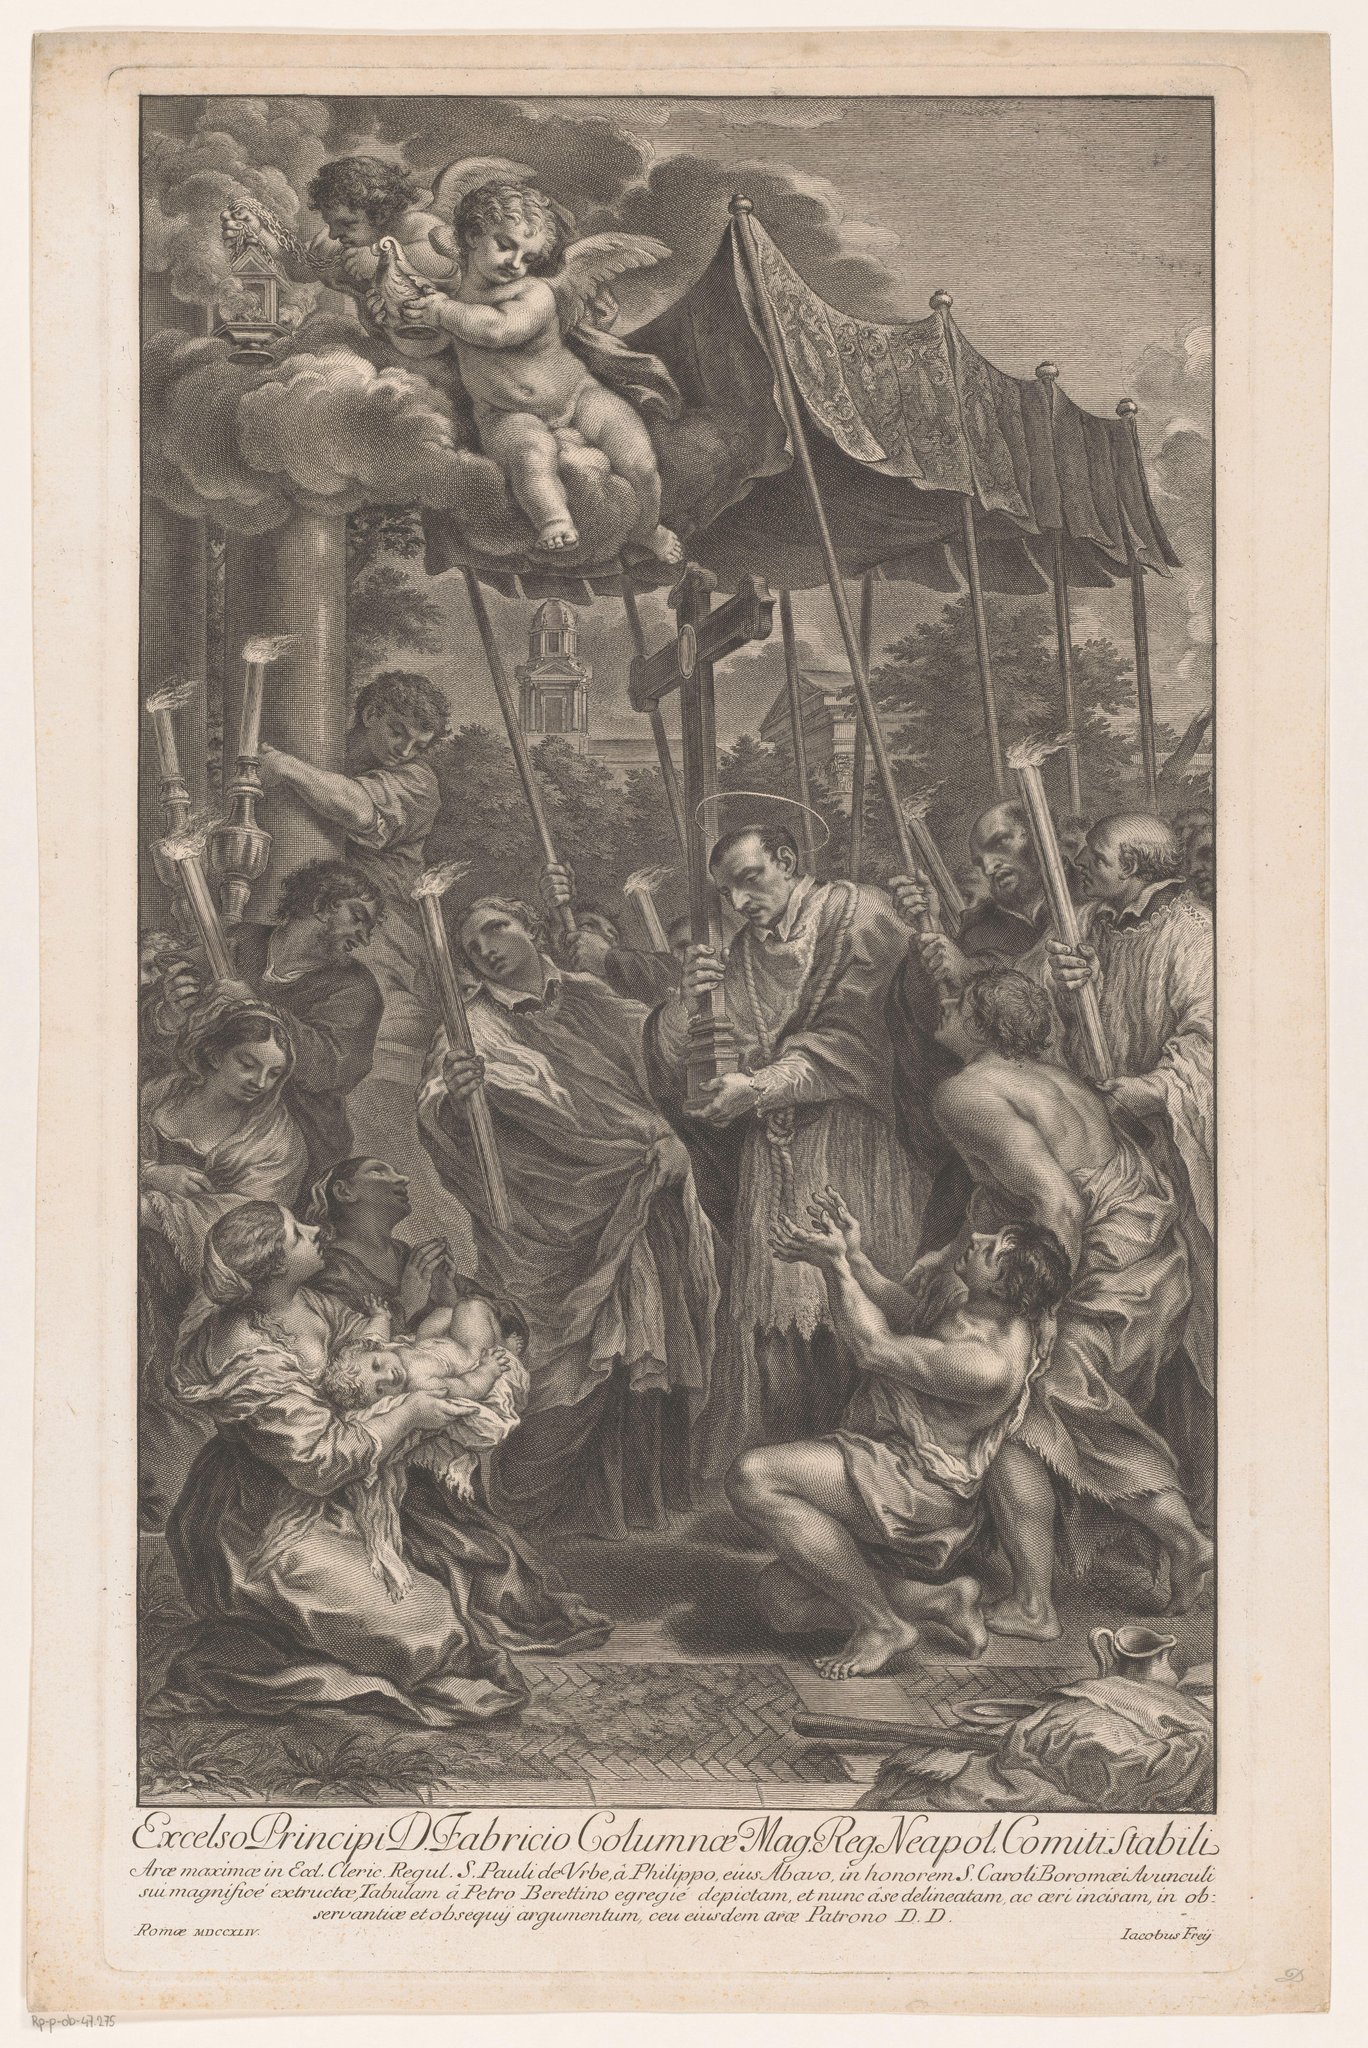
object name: print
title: H. Carolus Borromeus draagt een crucifix langs slachtoffers van de pest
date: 1744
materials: paper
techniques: engraving, etching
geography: rome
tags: altarcross, crucifix, charles borromeo, cardinal of milan; possible attributes: cardinal's hat, crucifix, rope round his neck, skull, procession ~ christian religion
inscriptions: collector's mark: Lugt 240